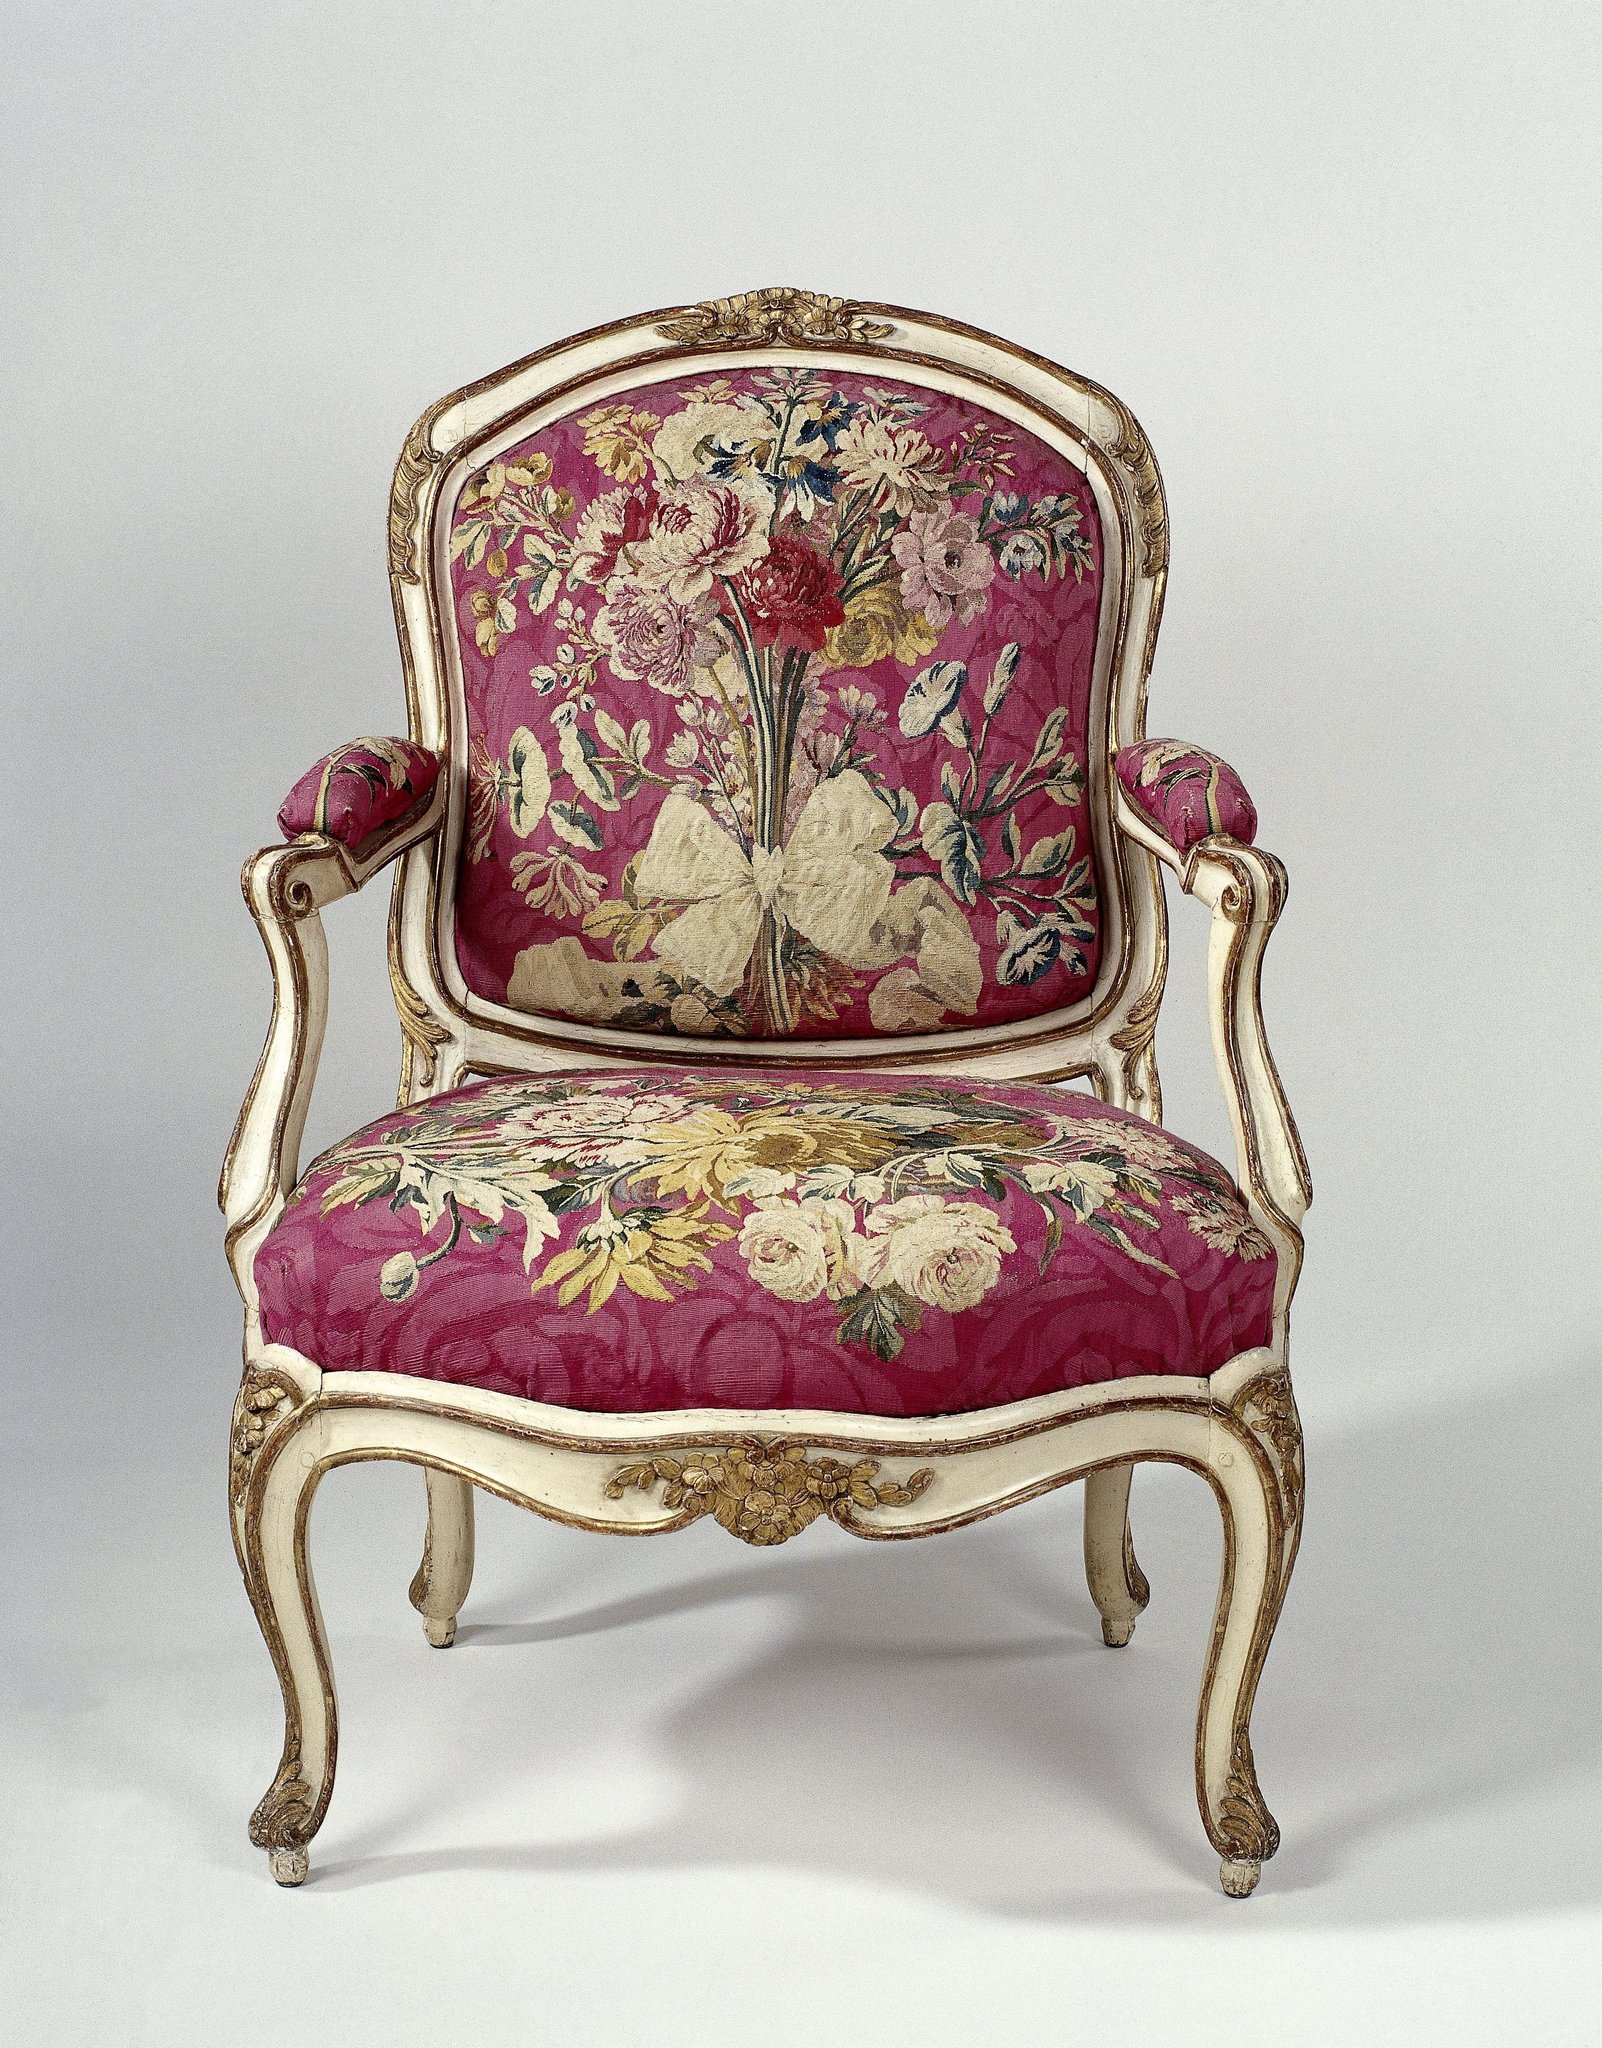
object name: suite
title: Armstoel bekleed met tapisserie met bloemboeketten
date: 1750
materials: wood, paint, silk, wool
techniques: gilding, tapestry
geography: paris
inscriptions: signature: ‘I. GOURDIN’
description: Two armchairs and a sofa. Beech, upholstered in tapestry. The chairs: Paris, c. 1750 - 1760, by Jean-Baptiste Gourdin. The sofa modern. De tapestry: Paris, Manufacture Royale des Gobelins, c. 1772. The tapestry upholstery was made for the Prince de Condé for the Chambre Rose at the Palais Bourbon in Paris. The original seat furniture to which it was applied does not survive.